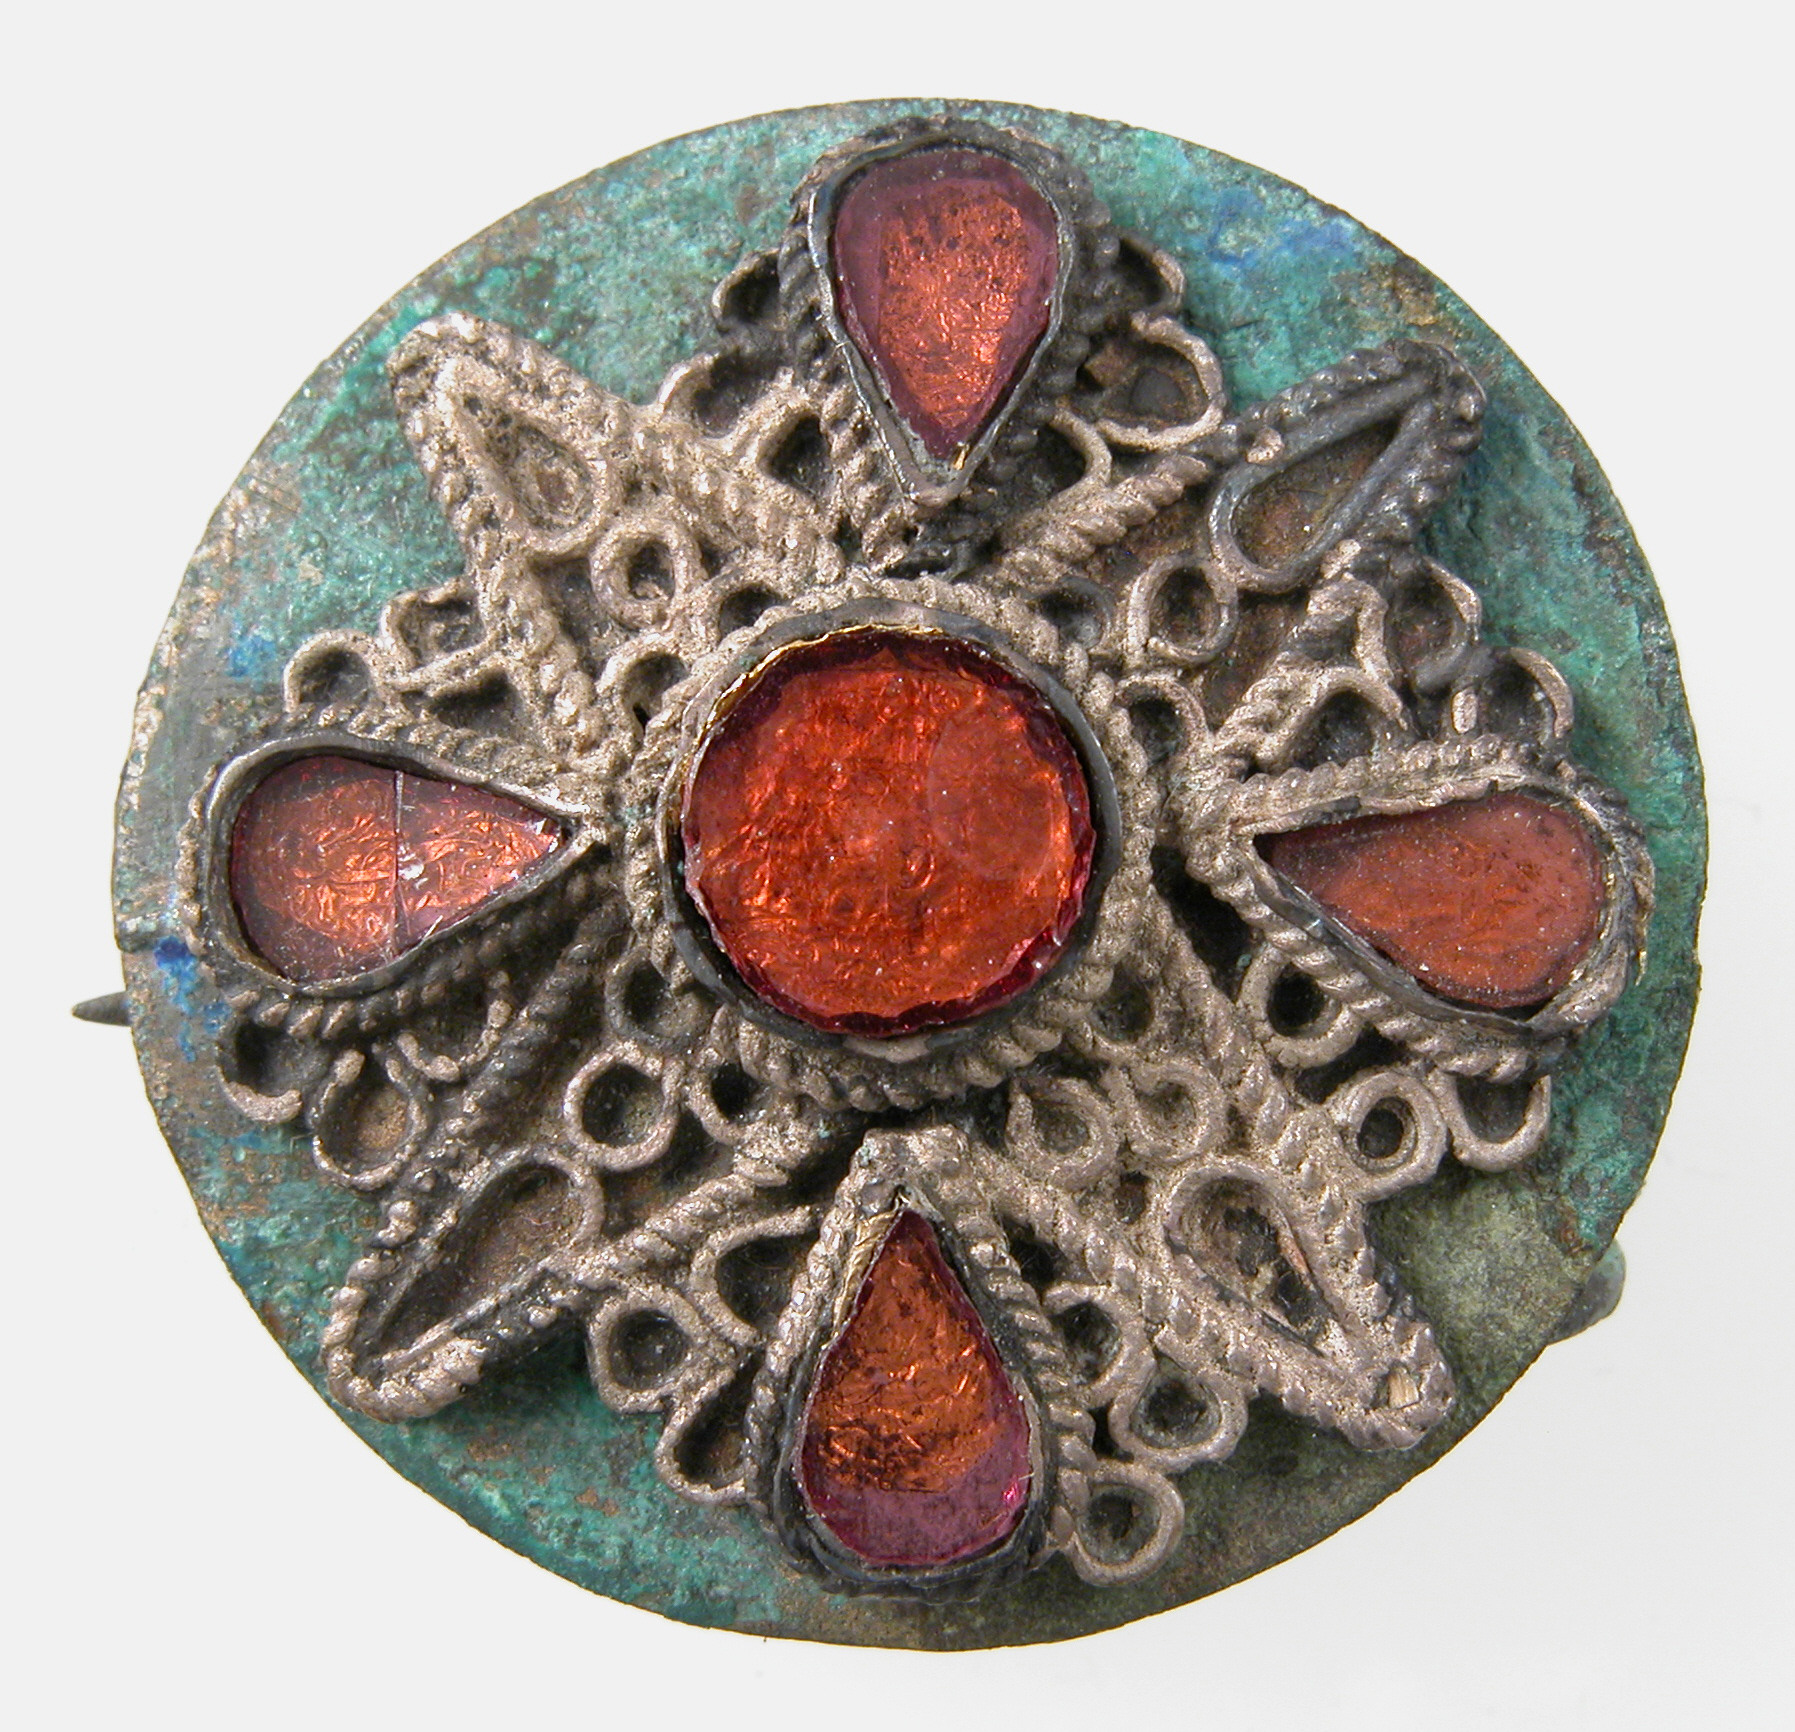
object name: brooch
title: Disk Brooch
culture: frankish or northern french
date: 550-600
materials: copper alloy, glass, paste, silver, metal